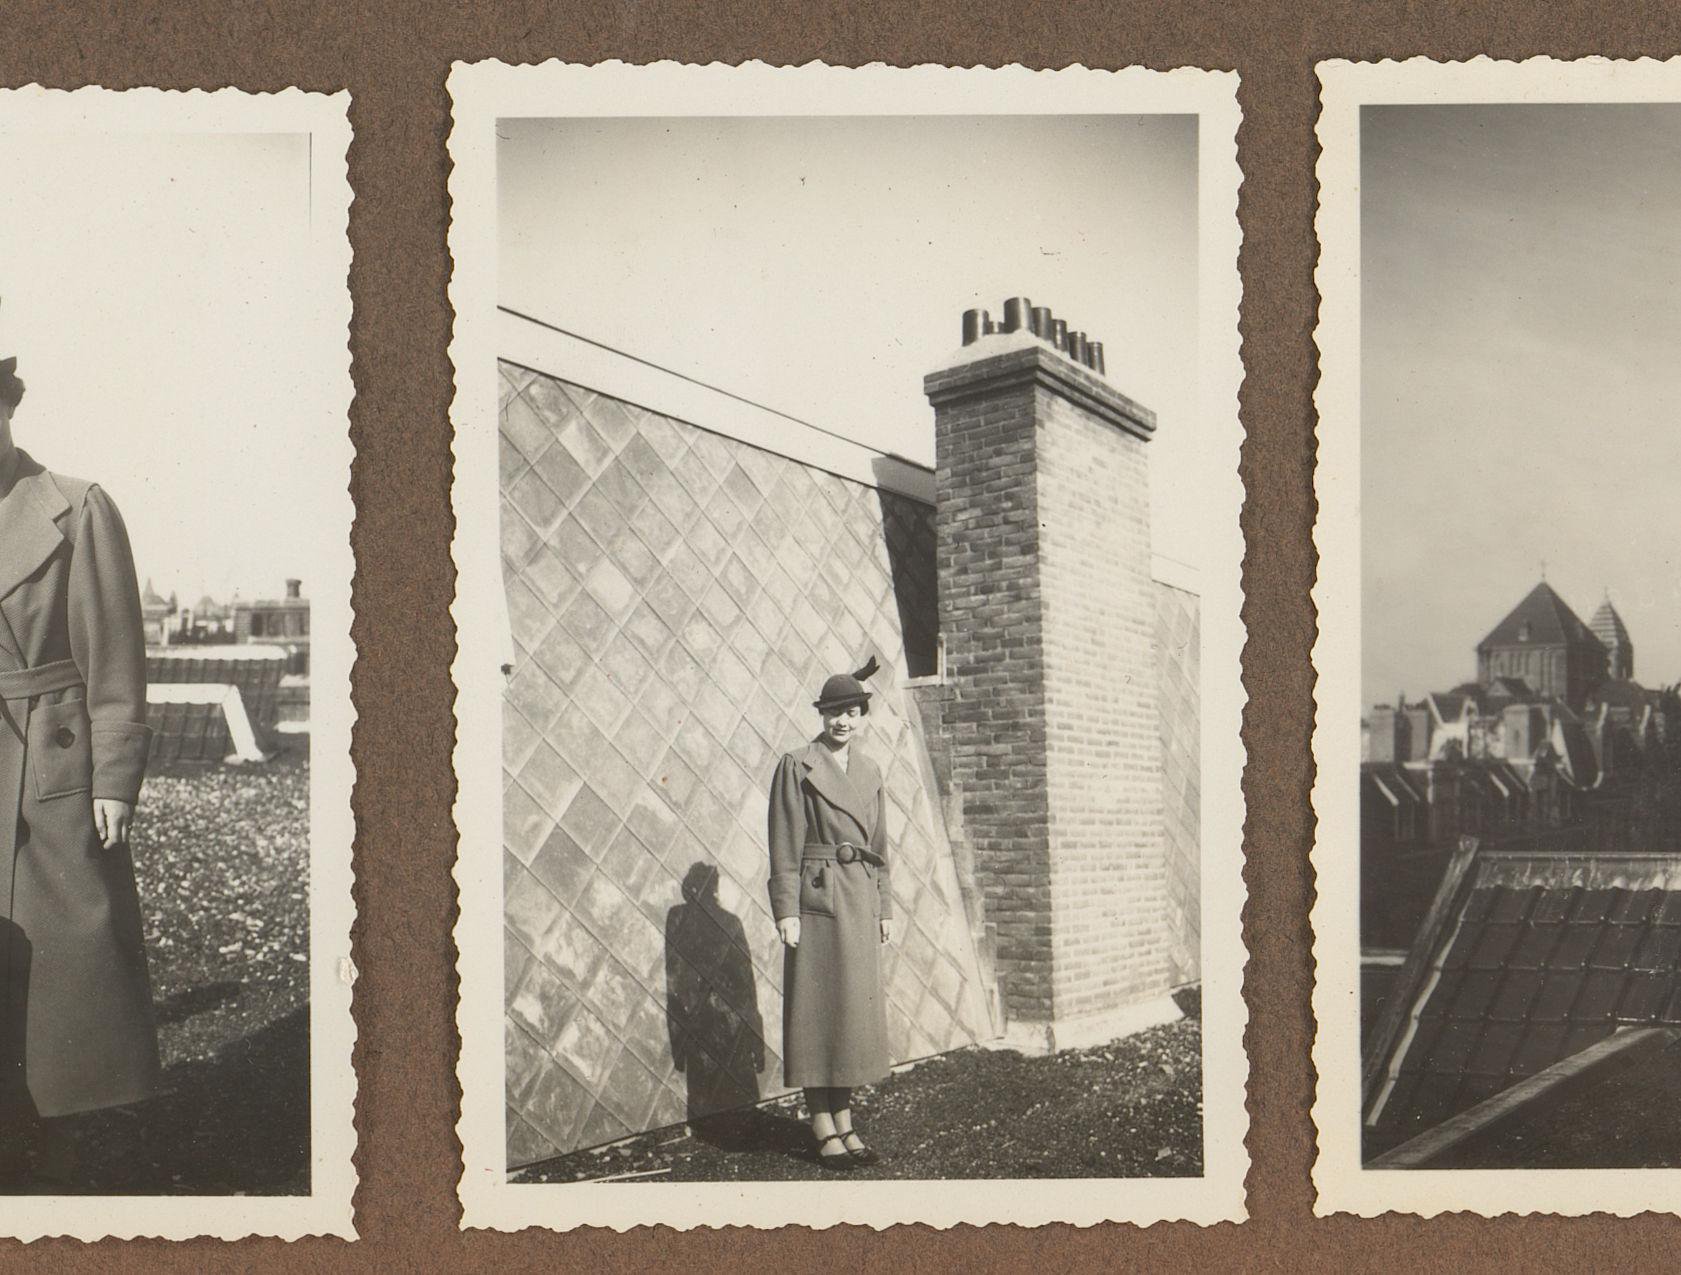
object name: photograph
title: Vrouw op Amsterdams dak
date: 1900-1920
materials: photographic support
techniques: photography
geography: amsterdam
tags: amsterdam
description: Foto op bruin albumblad 55 van familiealbum van Alphons Diepenbrock.